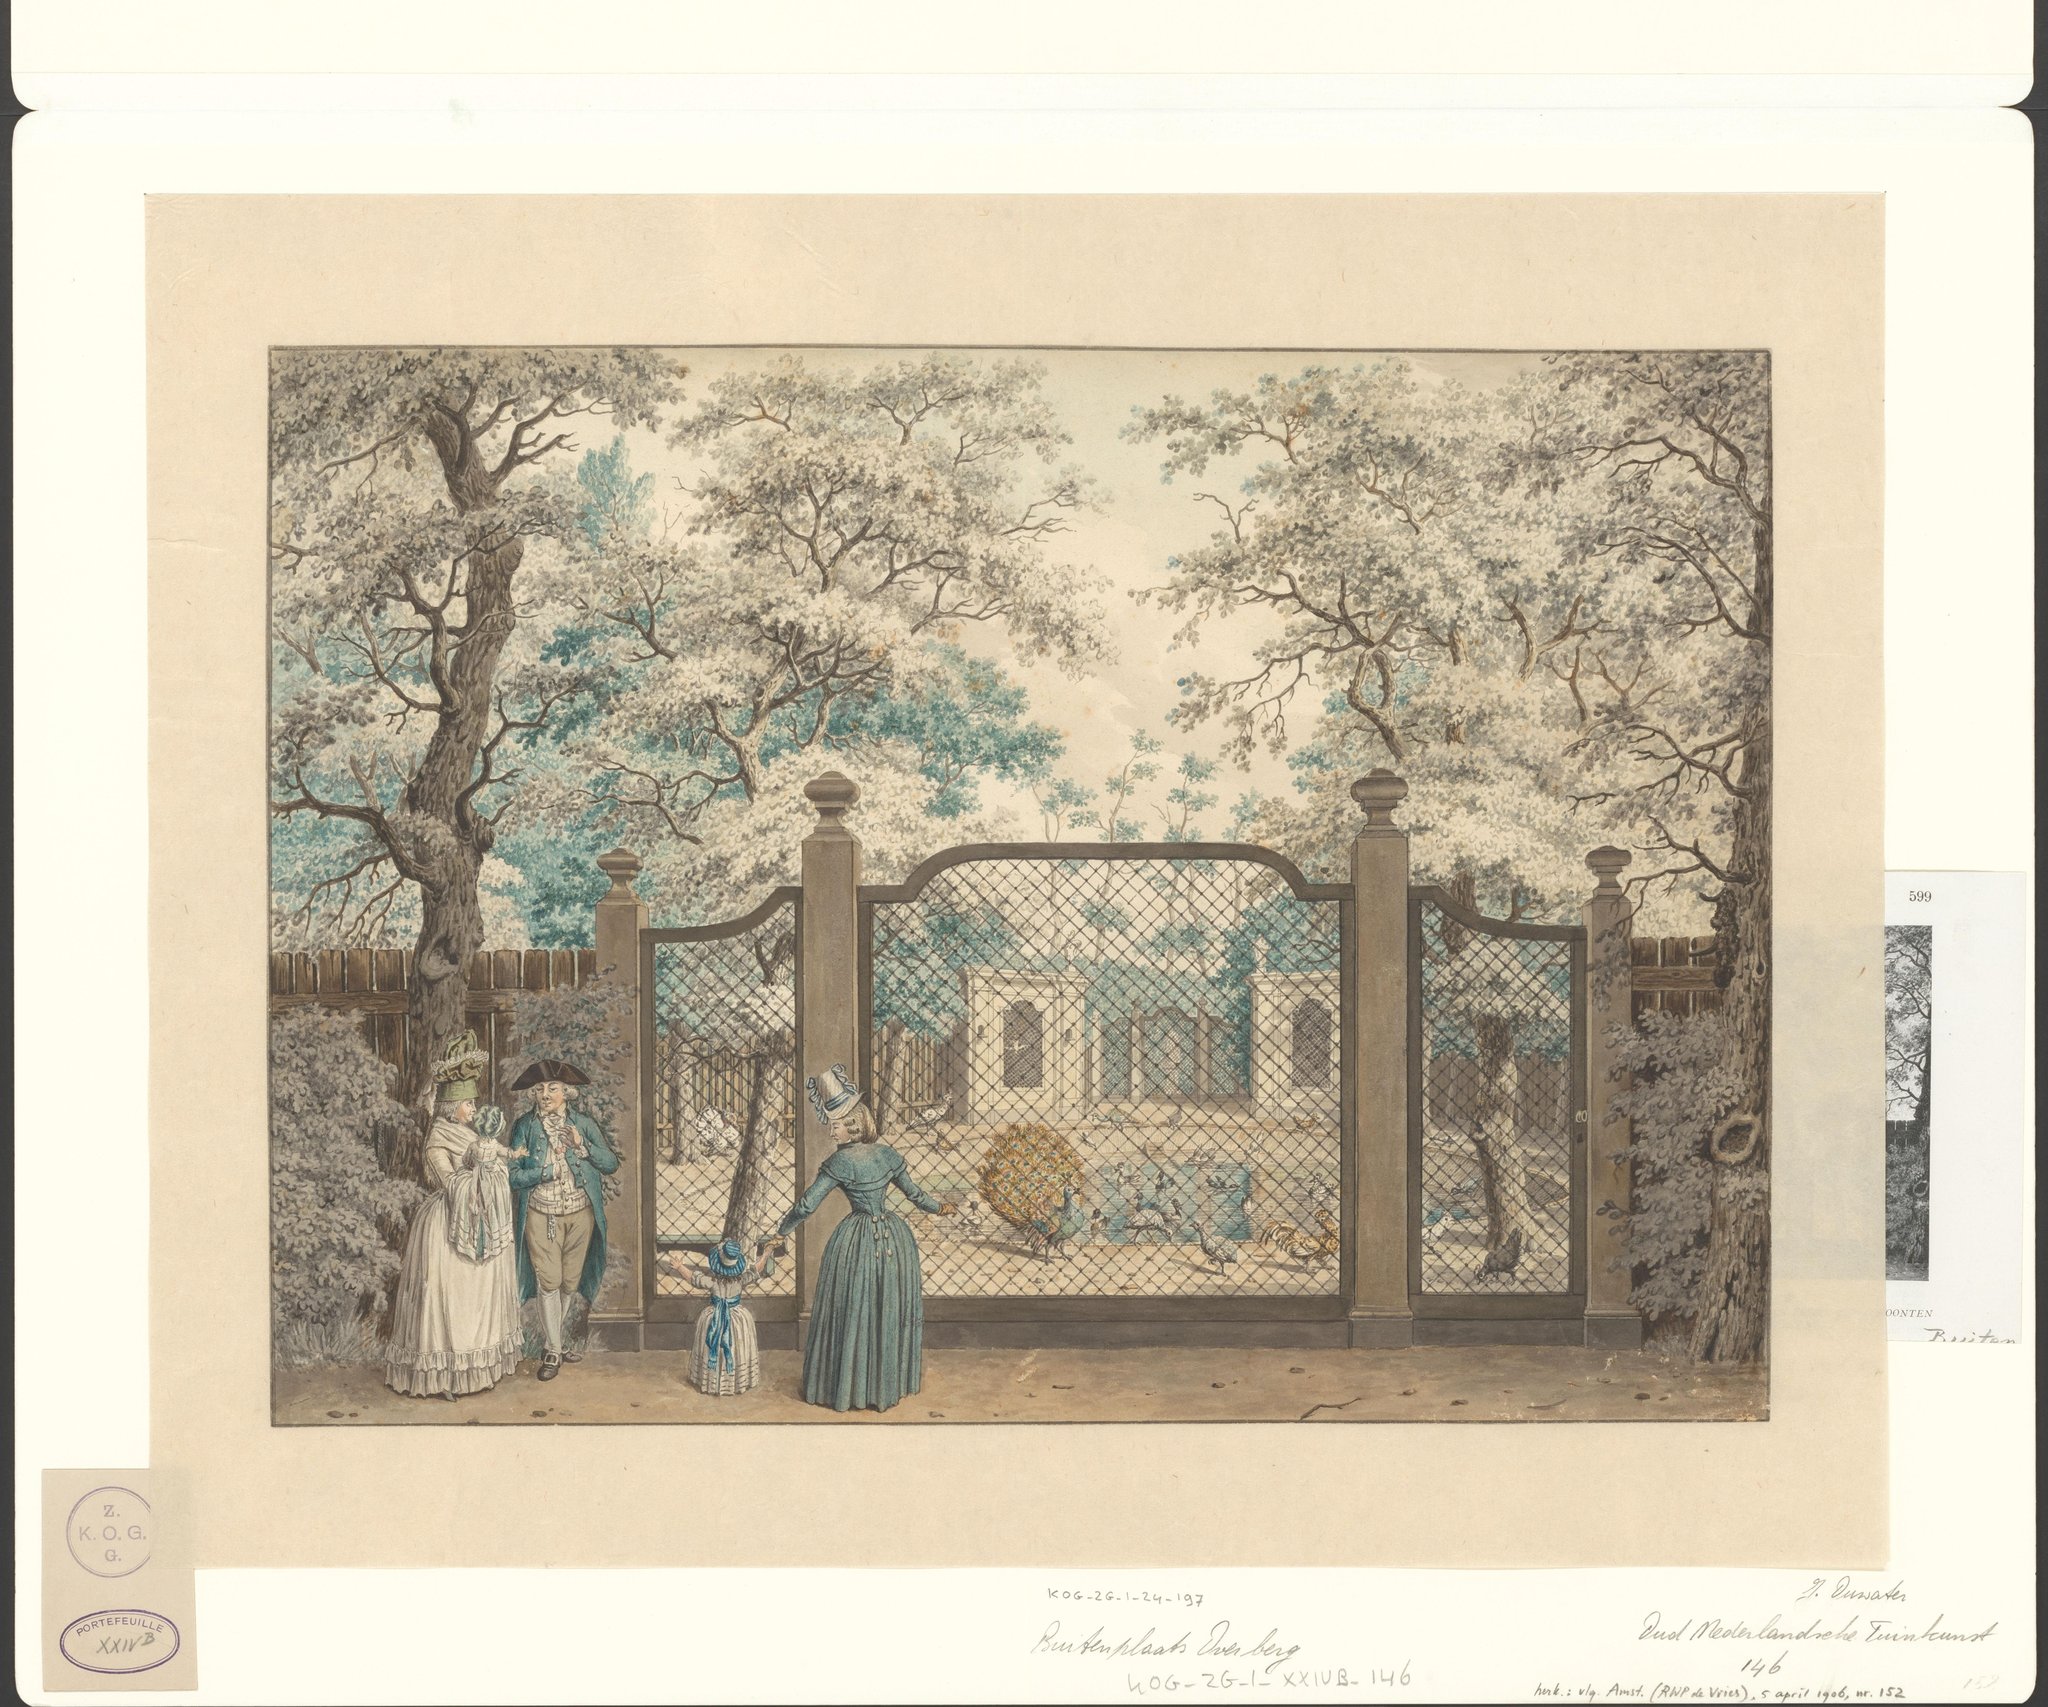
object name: drawing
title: Familie voor de volière van Buitenplaats Overberg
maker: isaac ouwater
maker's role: draughtsman, painter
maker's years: 1748-1793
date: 1758-1793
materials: ink, paper, pencil, watercolor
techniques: brush, pen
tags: birds in a large cage, aviary, ornamental birds: peacock, country-house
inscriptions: collector's mark: Lugt 1641, stamp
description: Onderwerpsrubrieken binnen de Atlas Zeden en Gewoonten: Zeden en Gewoonten in Engeren Zin, De Woning, Oude Nederlandsche Tuinkunst. De 18de eeuw. Tuinen in de Zaanstreek.